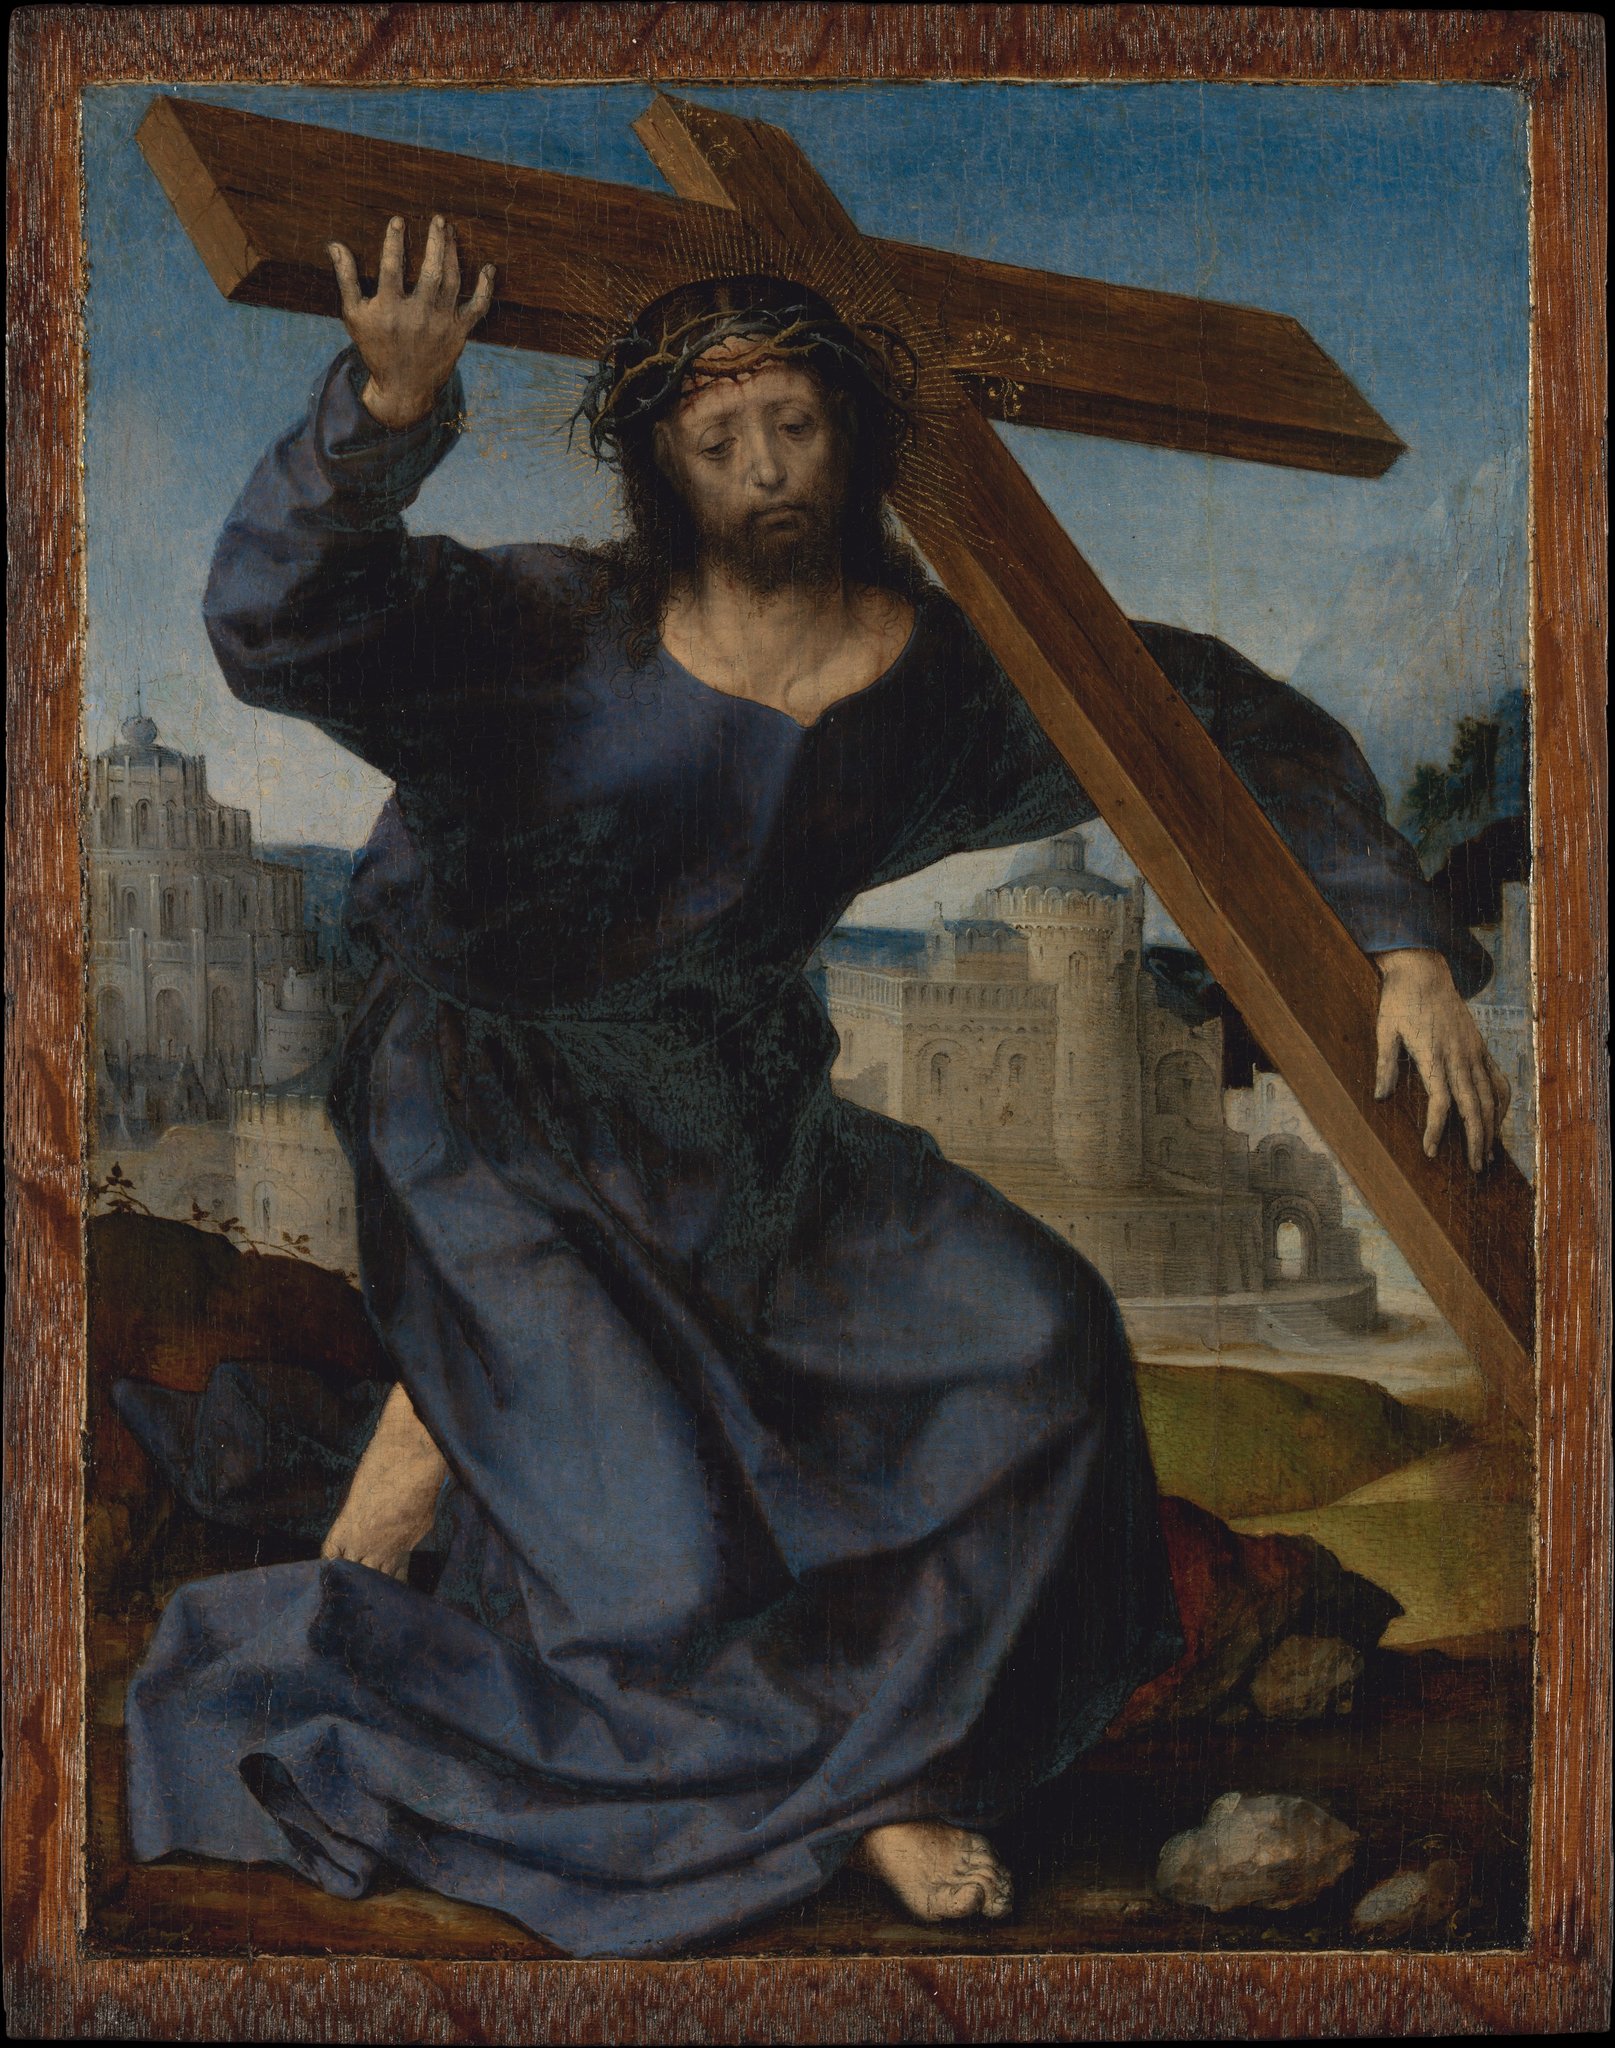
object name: painting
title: Christ Carrying the Cross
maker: jan gossart (called mabuse)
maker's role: artist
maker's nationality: netherlandish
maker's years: 1478-1532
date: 1520-1525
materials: wood, oil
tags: christ,cross,bearing the cross